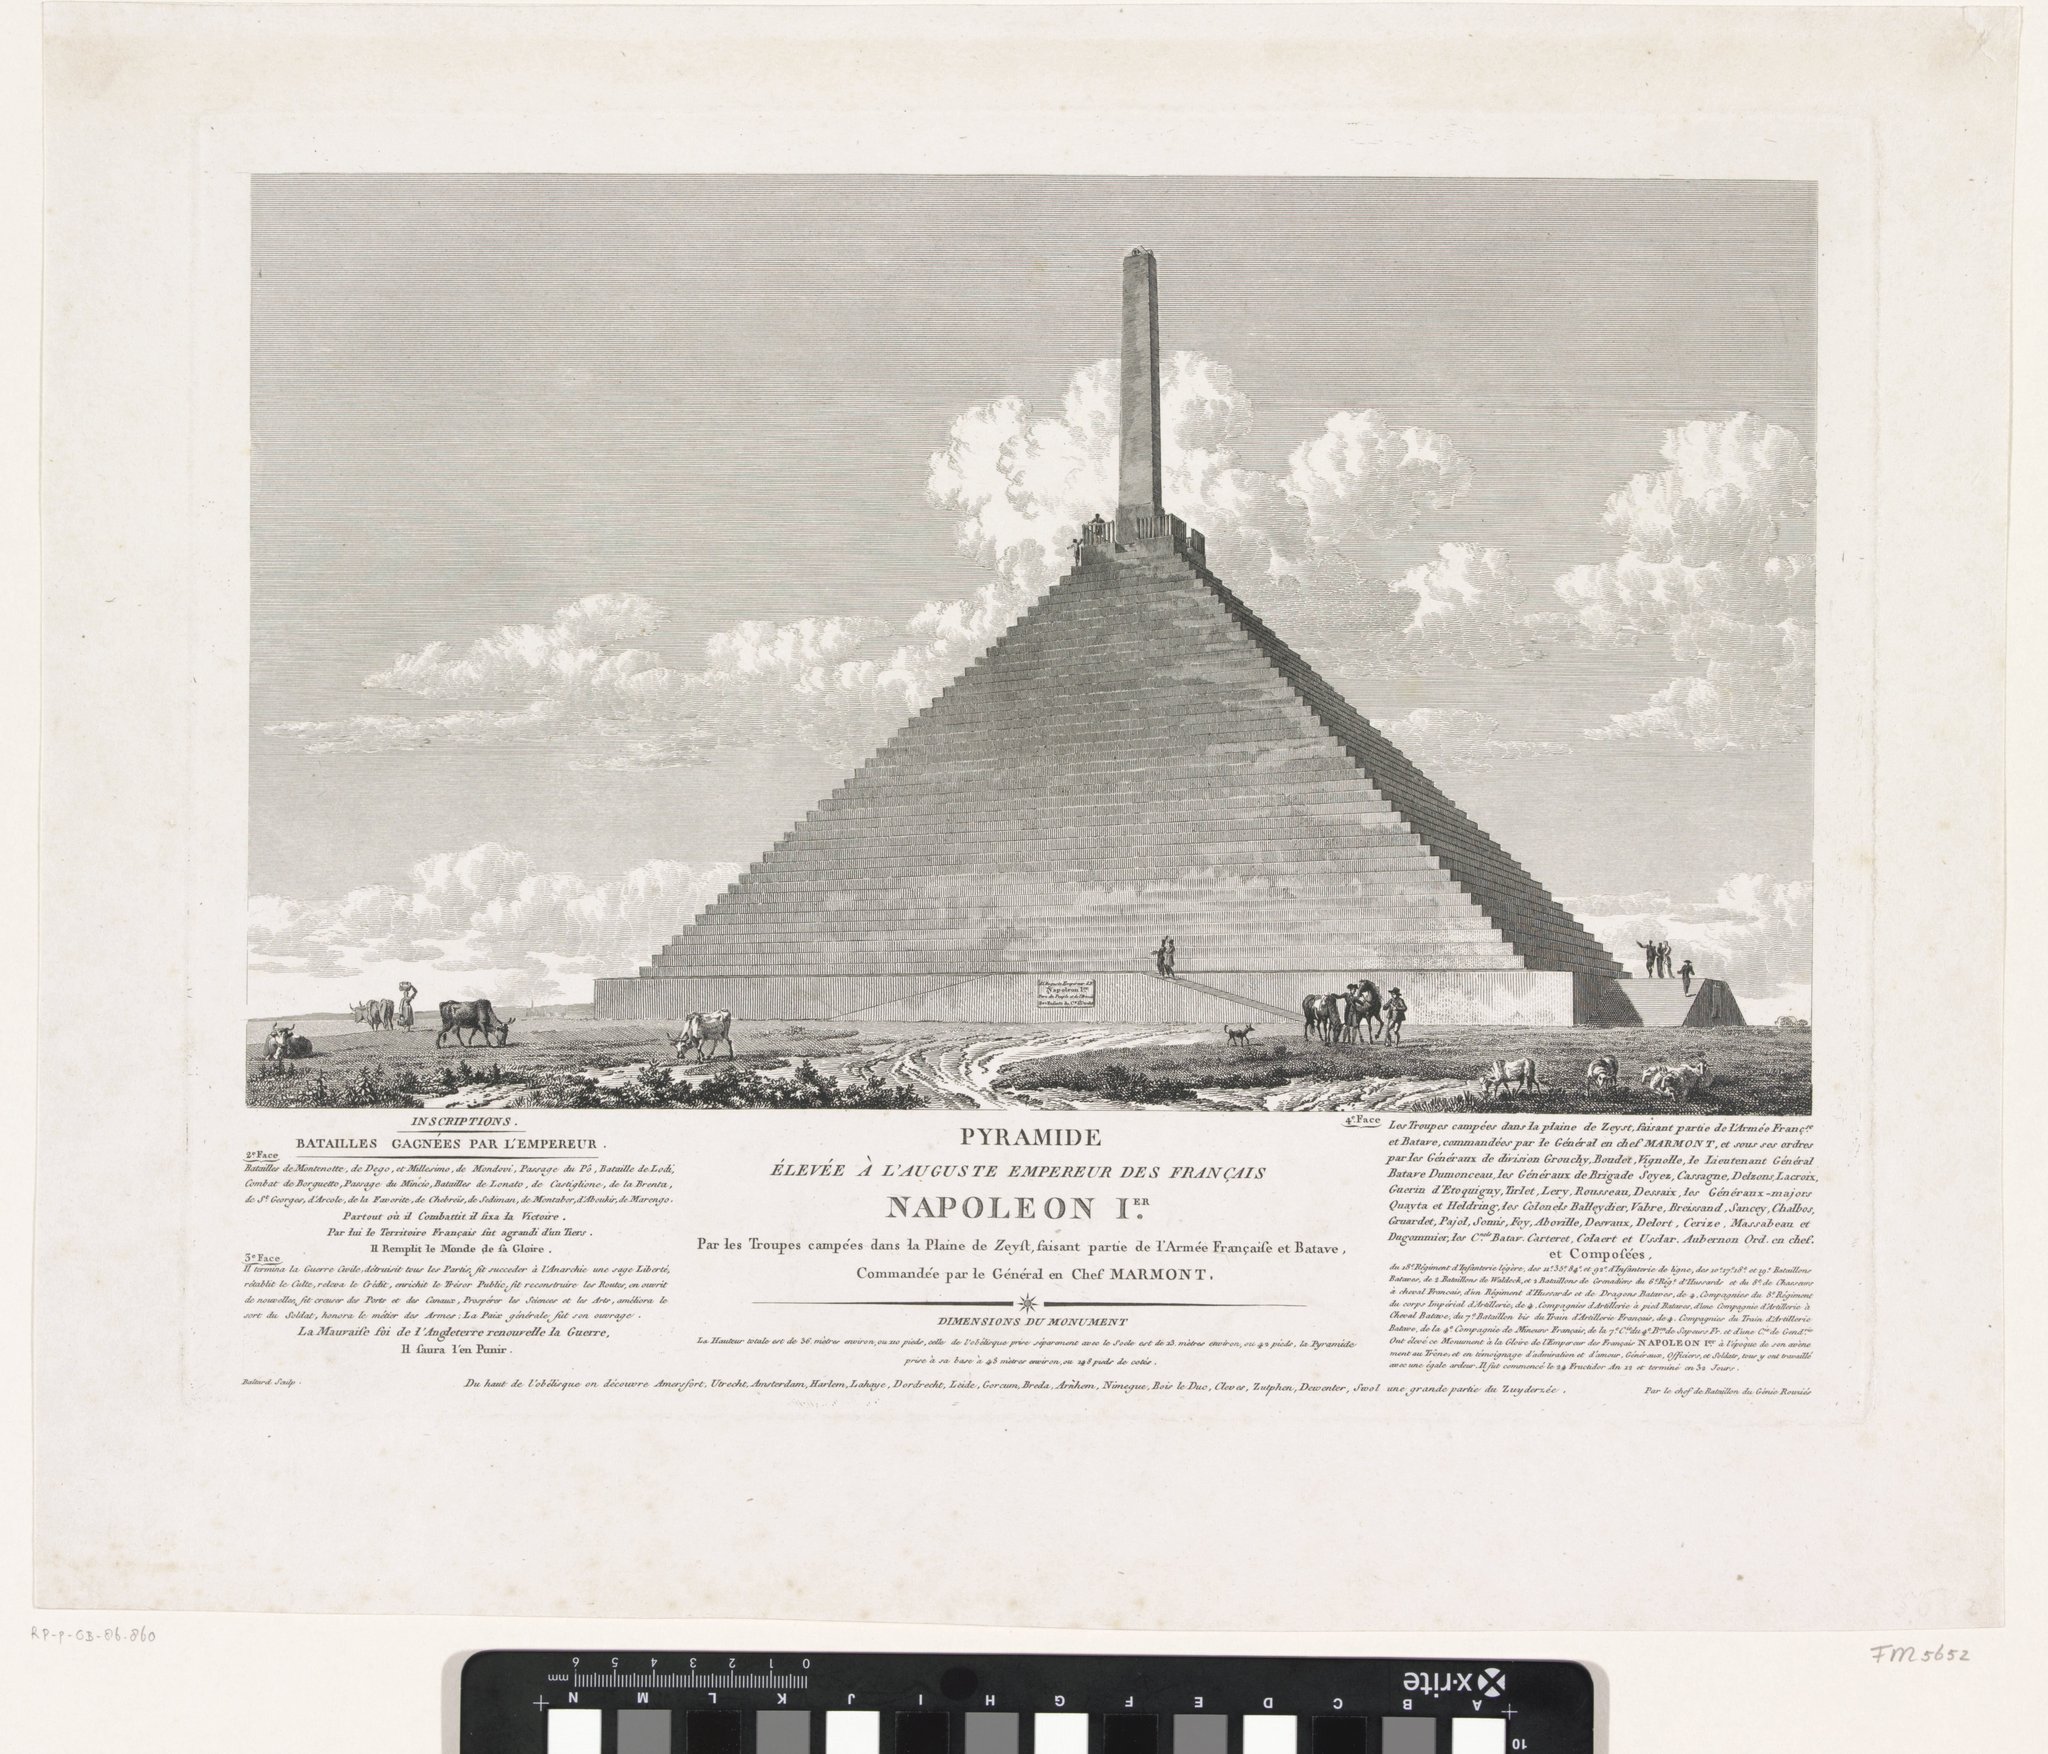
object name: print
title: Pyramide élevée à l'auguste empereur des Français Napoleon Ier. par les Troupes campéesdans la Plaine de Zeyst, faisant partie de l'Armée Française et Batave, Commandé par le Général en Chef Marmont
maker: louis pierre baltard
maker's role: print maker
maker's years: 1764-1846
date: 1805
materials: paper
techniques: engraving, etching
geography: france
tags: landscape with monument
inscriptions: collector's mark: Lugt 2228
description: Gezicht op de Pyramide van Austerlitz, gebouwd door de soldaten van Napoleon in 1804-1805. In het onderschrift de Franse inscripties die op de vier zijden van de piramide staan.